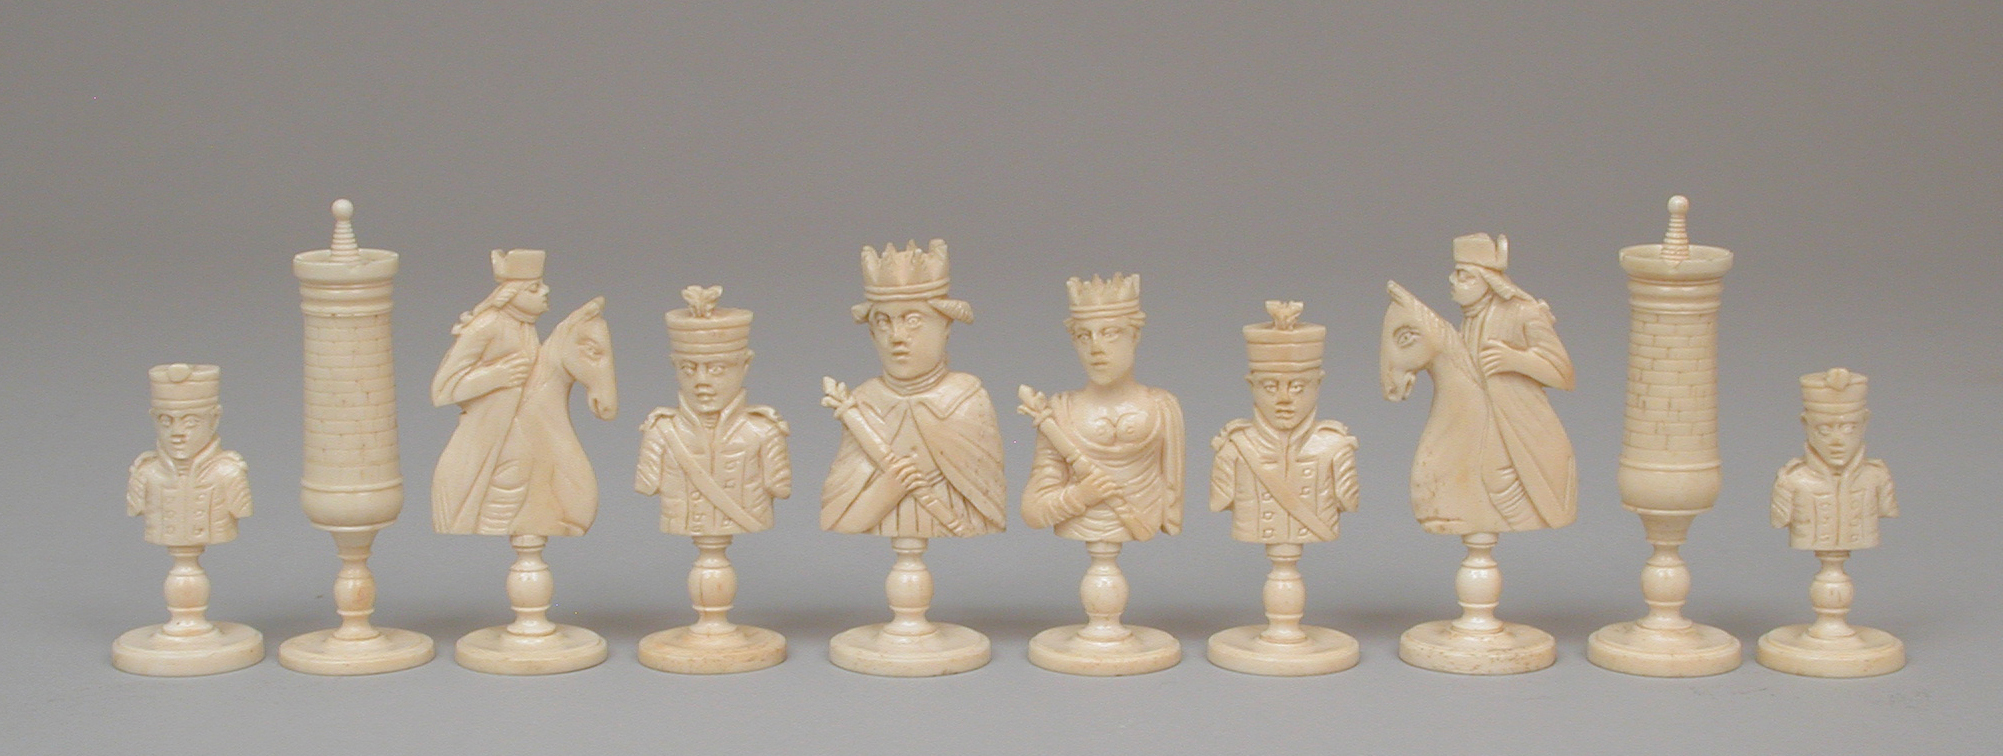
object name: chessman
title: Chessmen (32)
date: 1801-1850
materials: bone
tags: chess,games